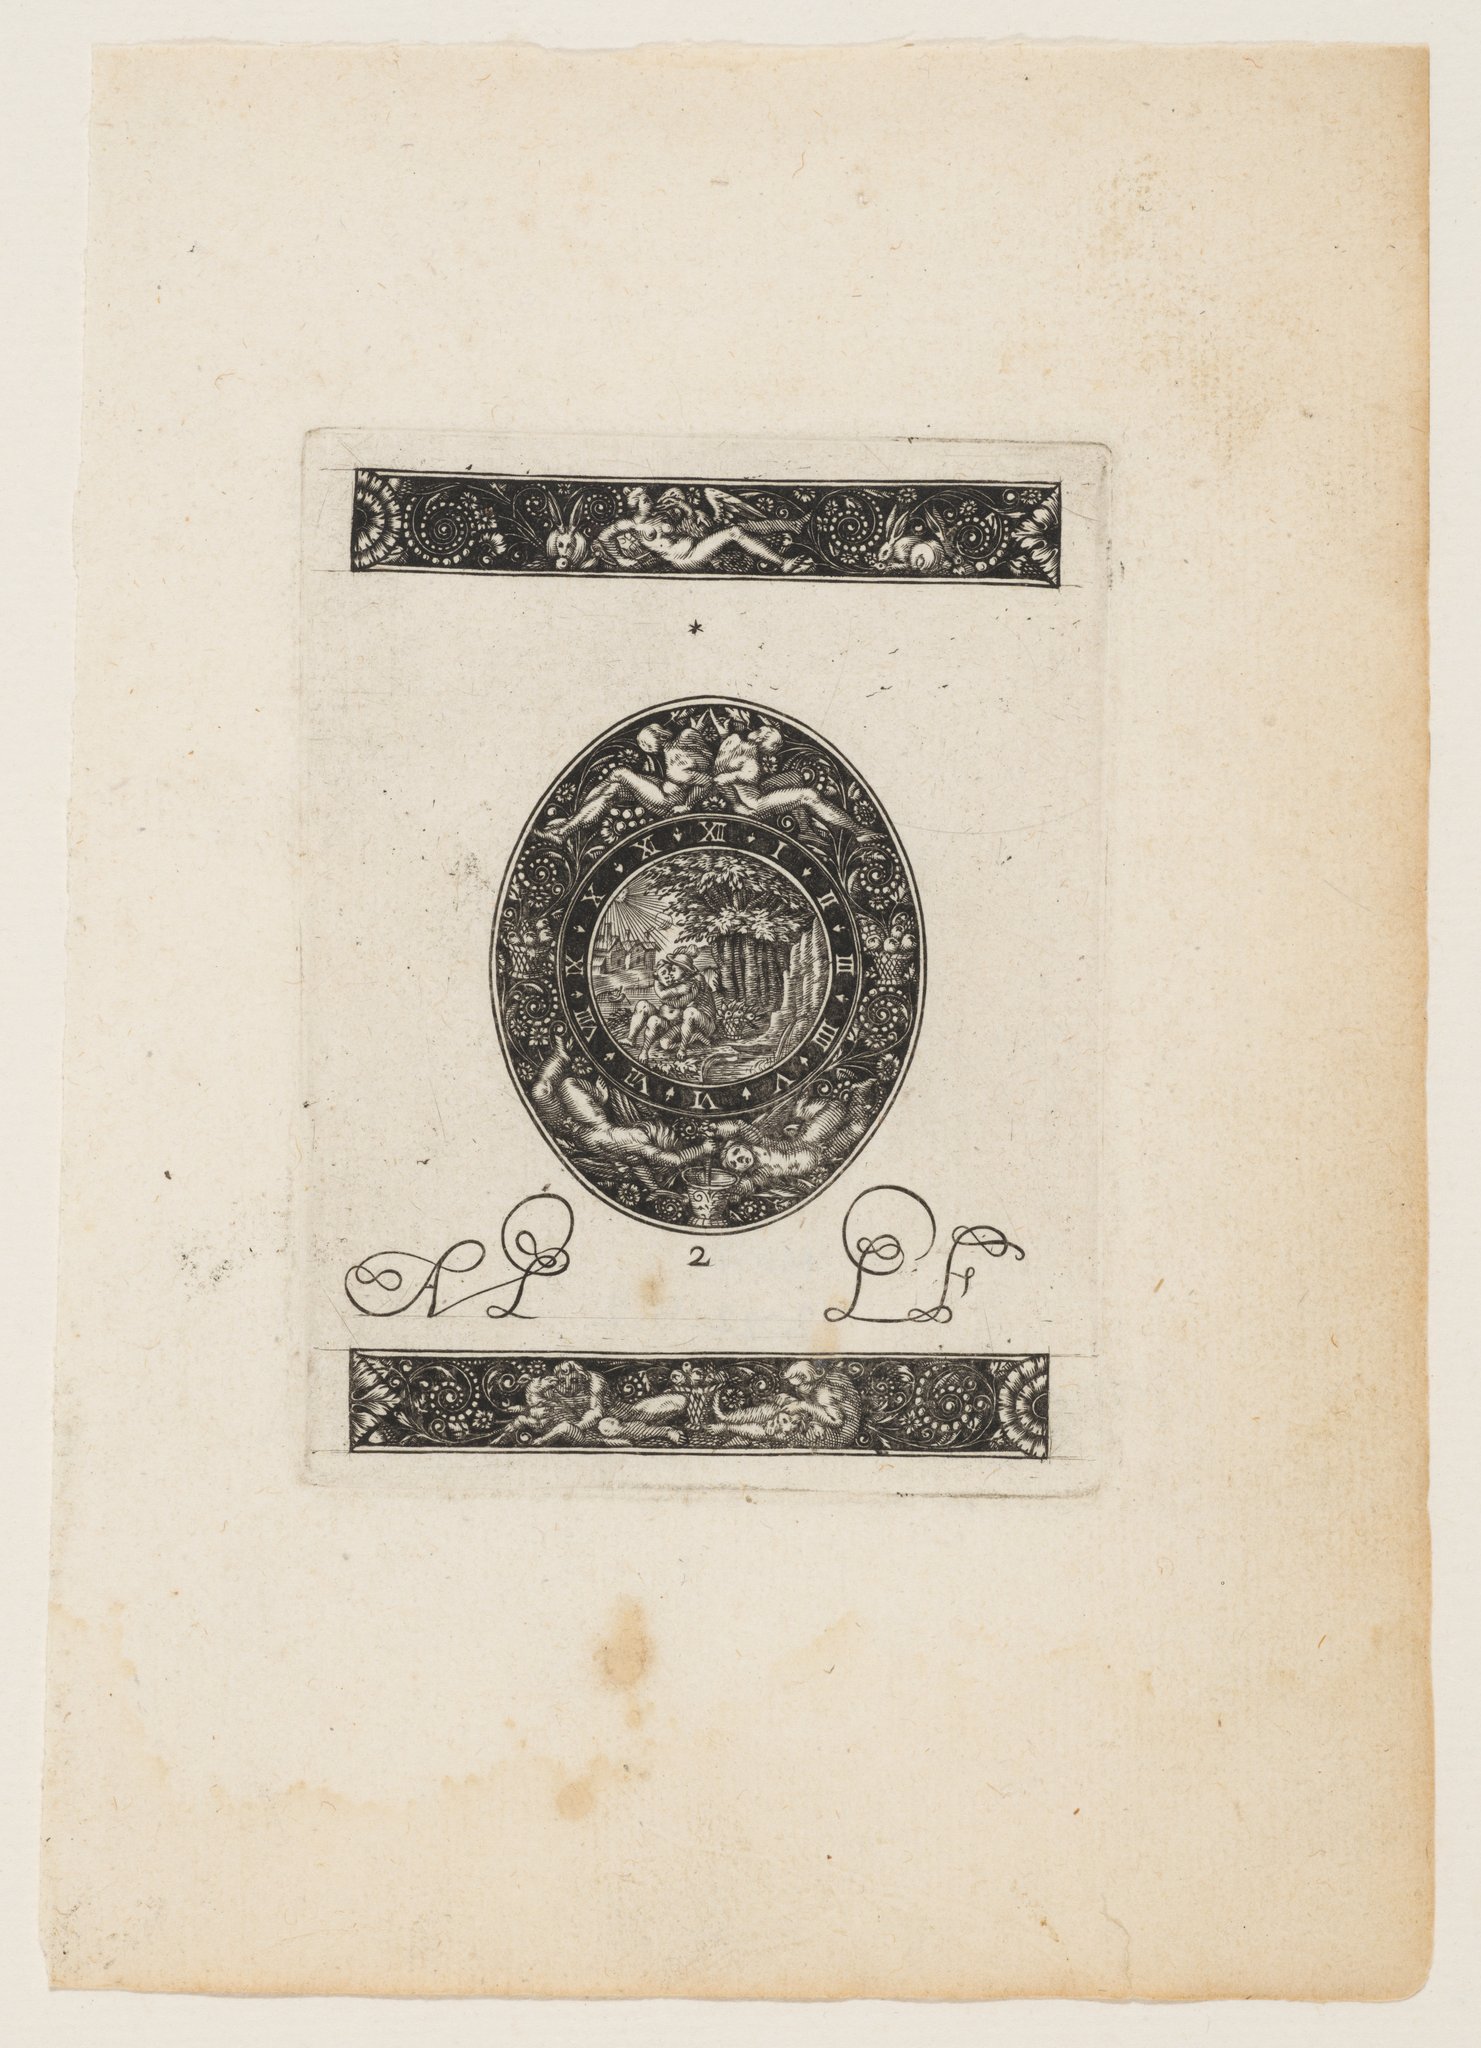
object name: ornament architectue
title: Oval Watch Plate with Diana and Endymion (?) embracing, from a Series of Six Designs for Watch Cases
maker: antoine jacquard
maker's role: artist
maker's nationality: french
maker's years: 1610-1630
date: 1610-1615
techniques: embroidery, engraving